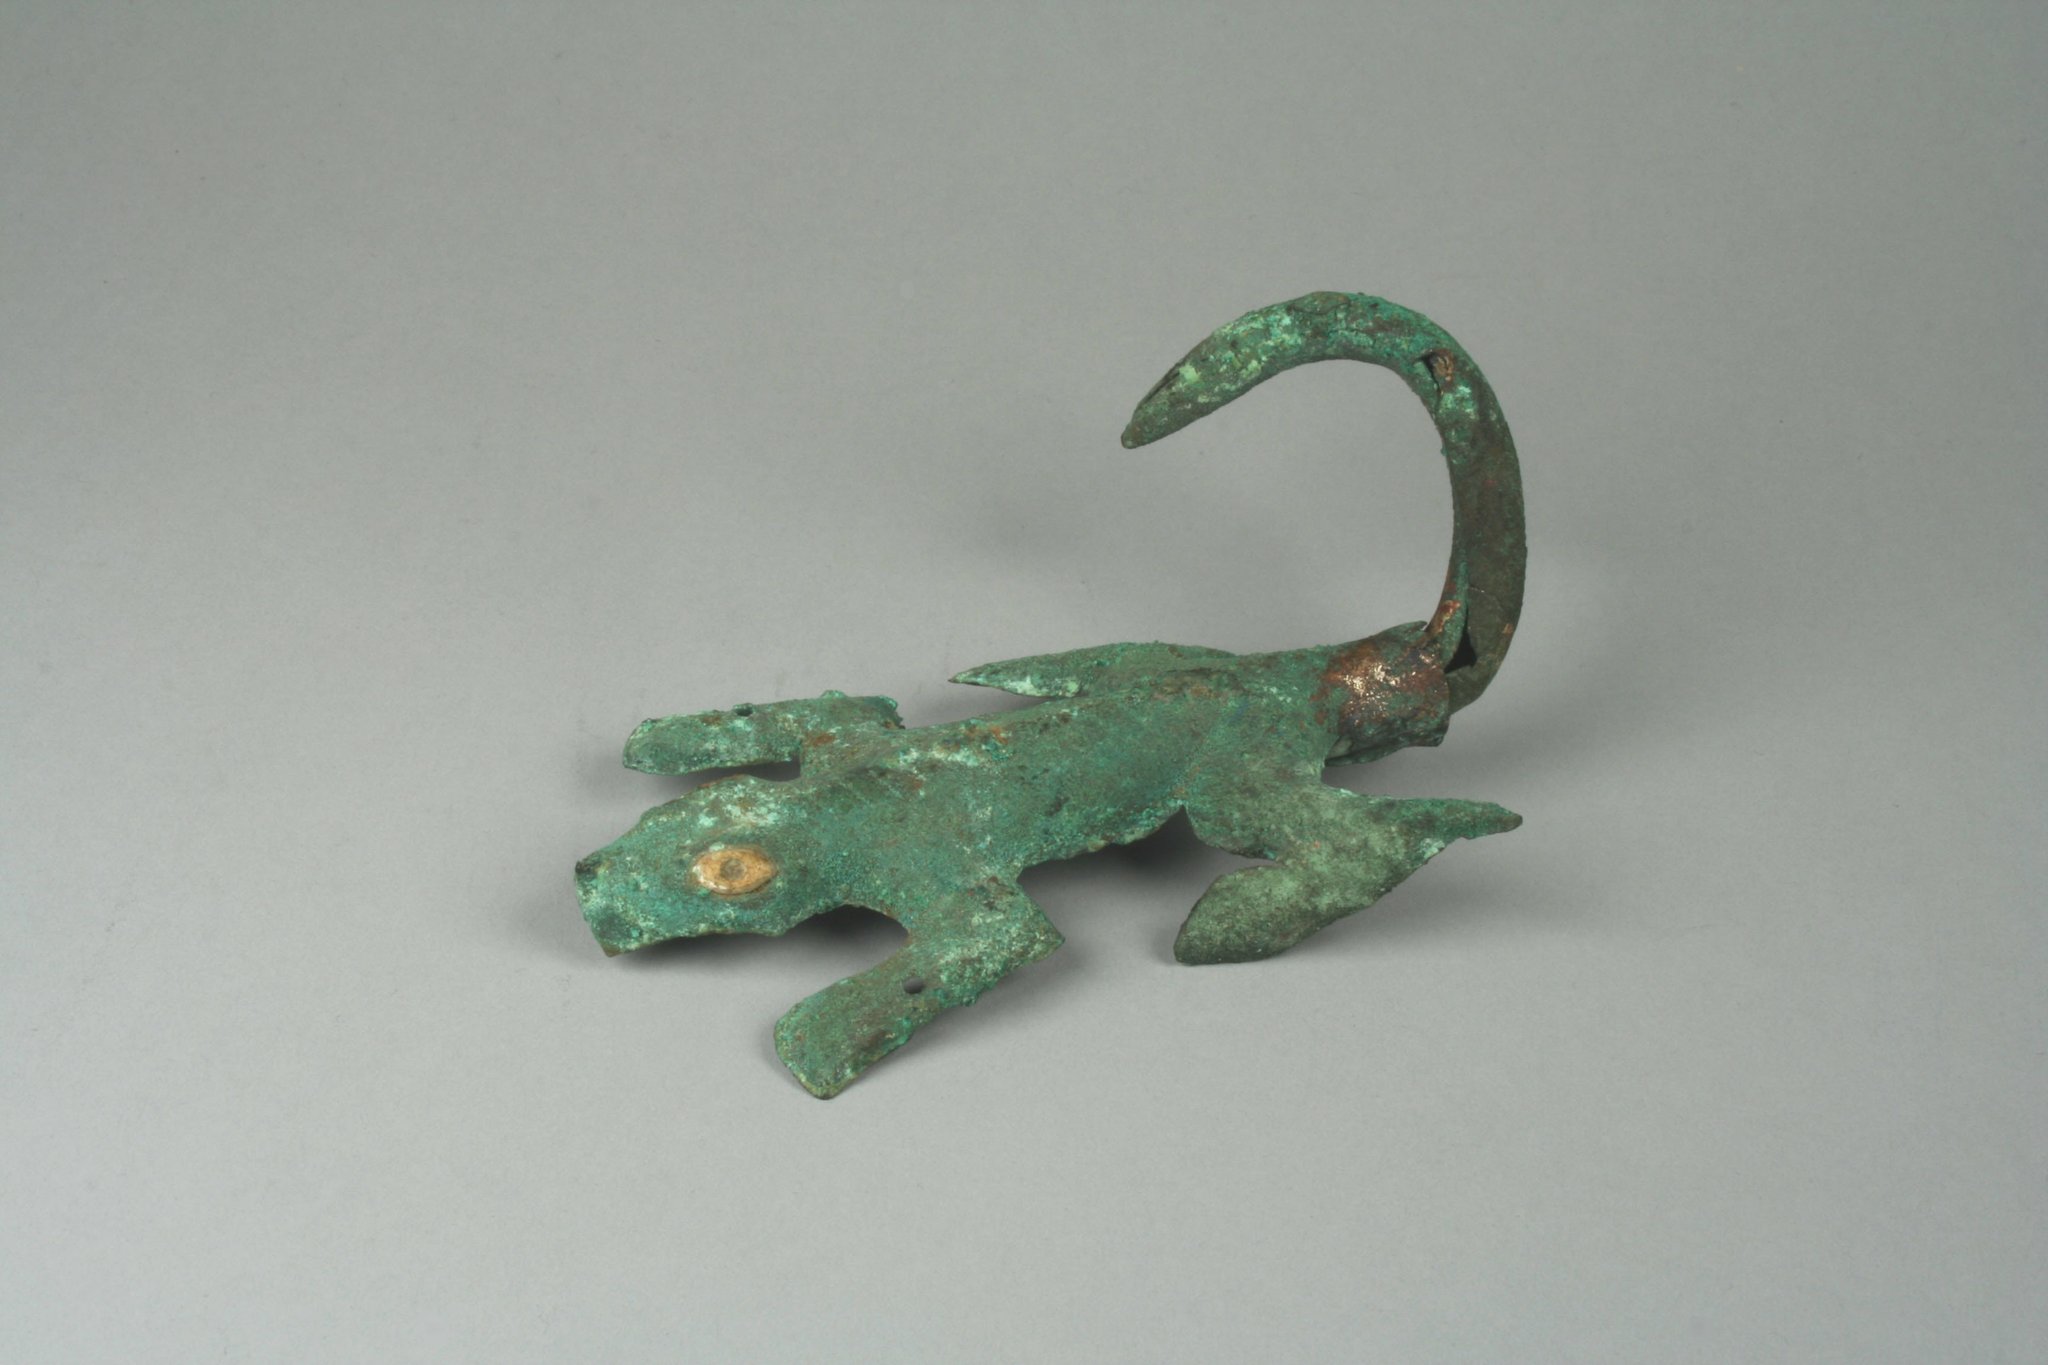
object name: ornament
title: Animal Ornament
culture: moche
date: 501-700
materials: gilt copper, shell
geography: peru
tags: lizards